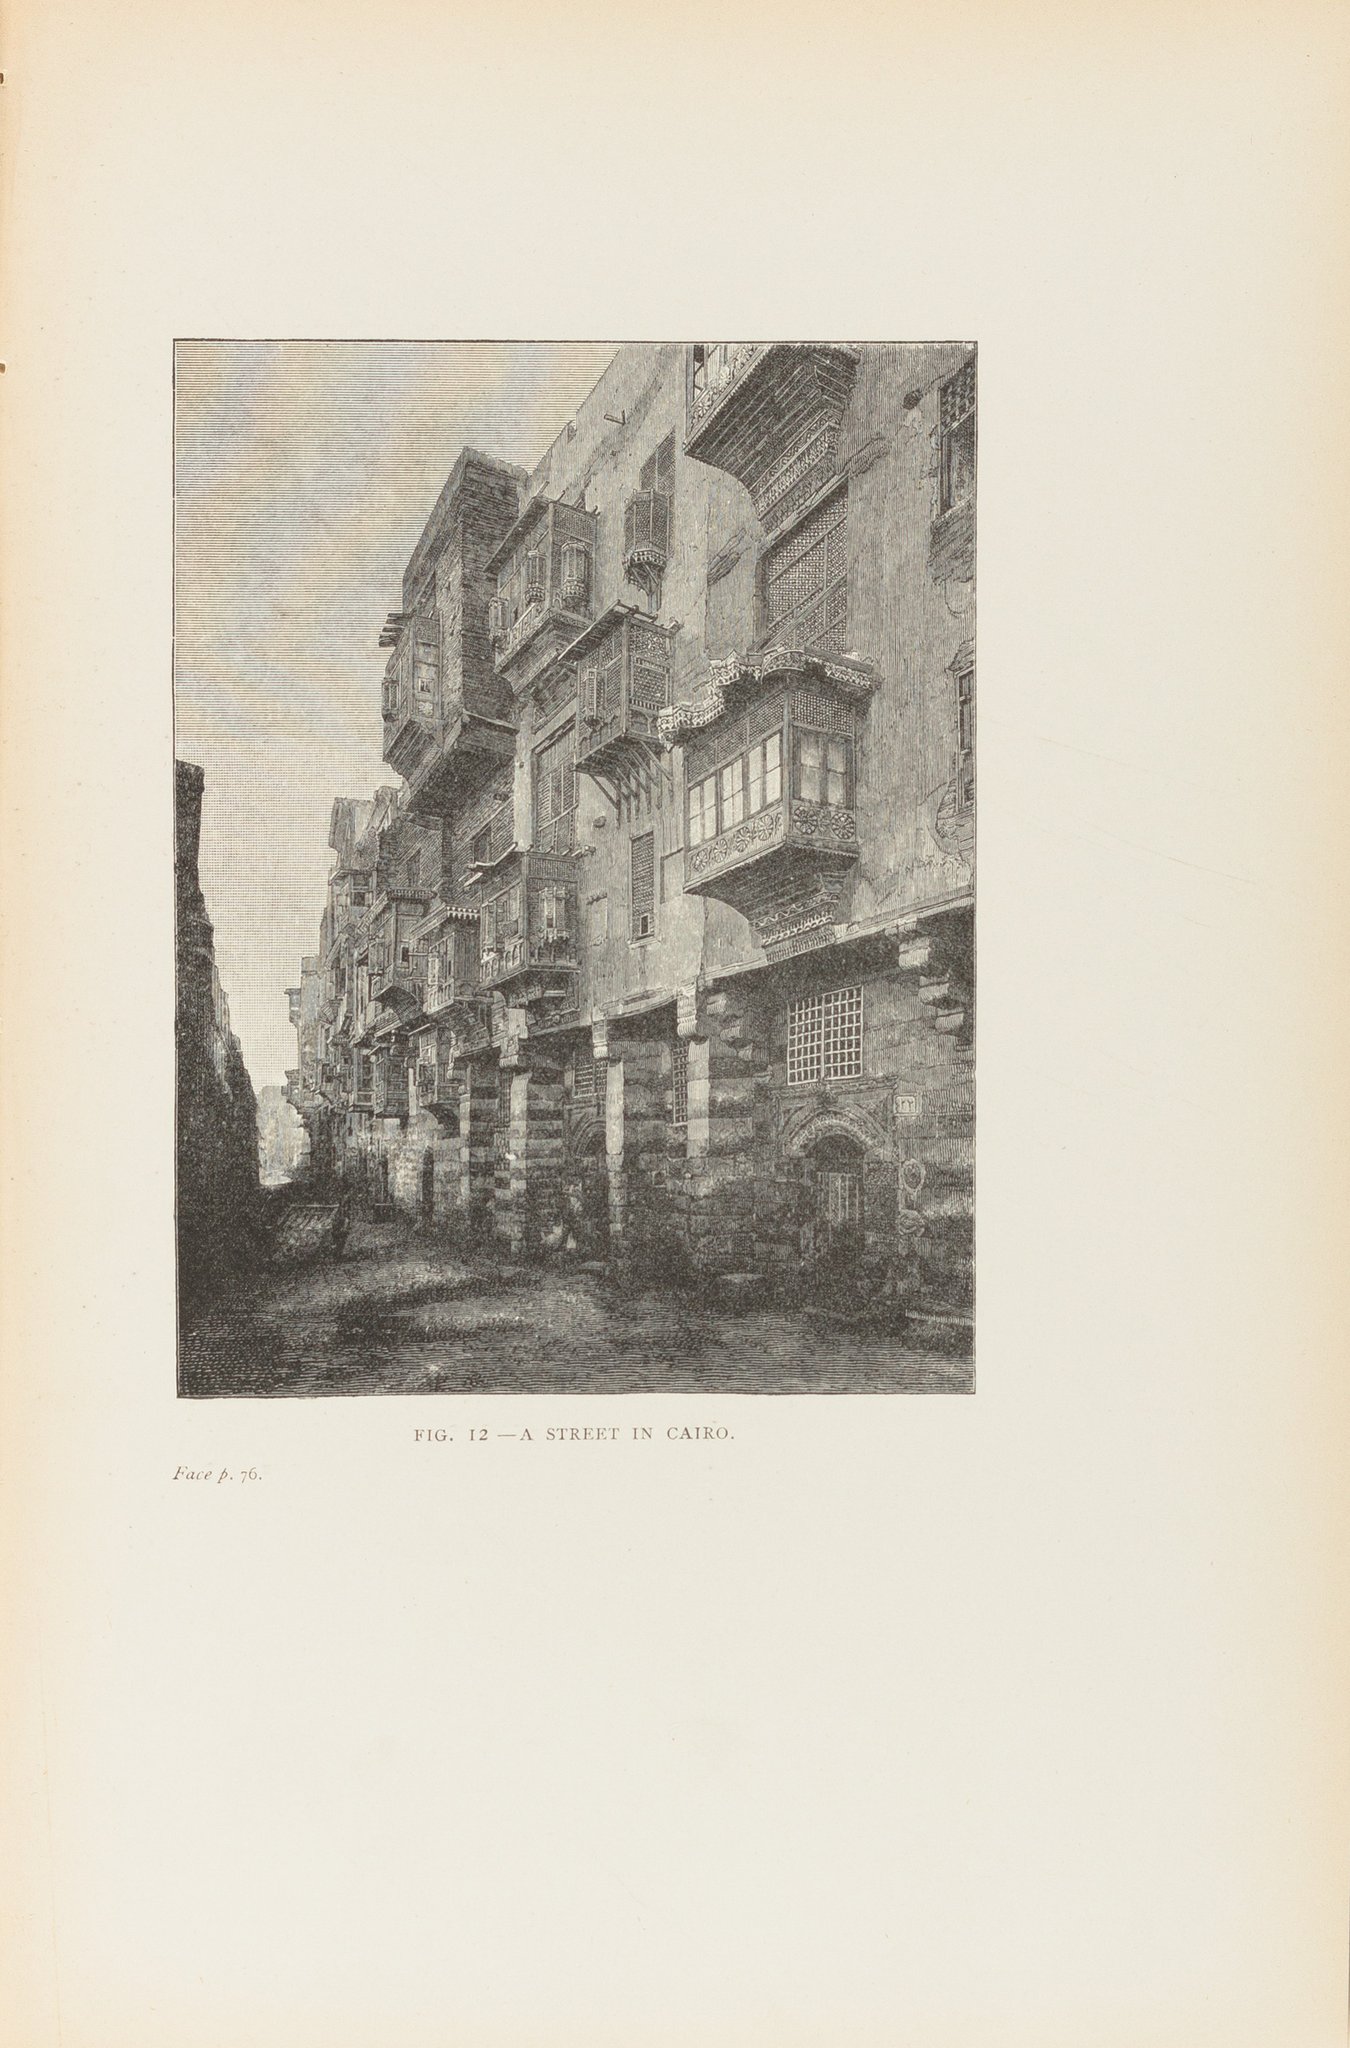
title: The art of the Saracens in Egypt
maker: stanley lane-poole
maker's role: author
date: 1886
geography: england